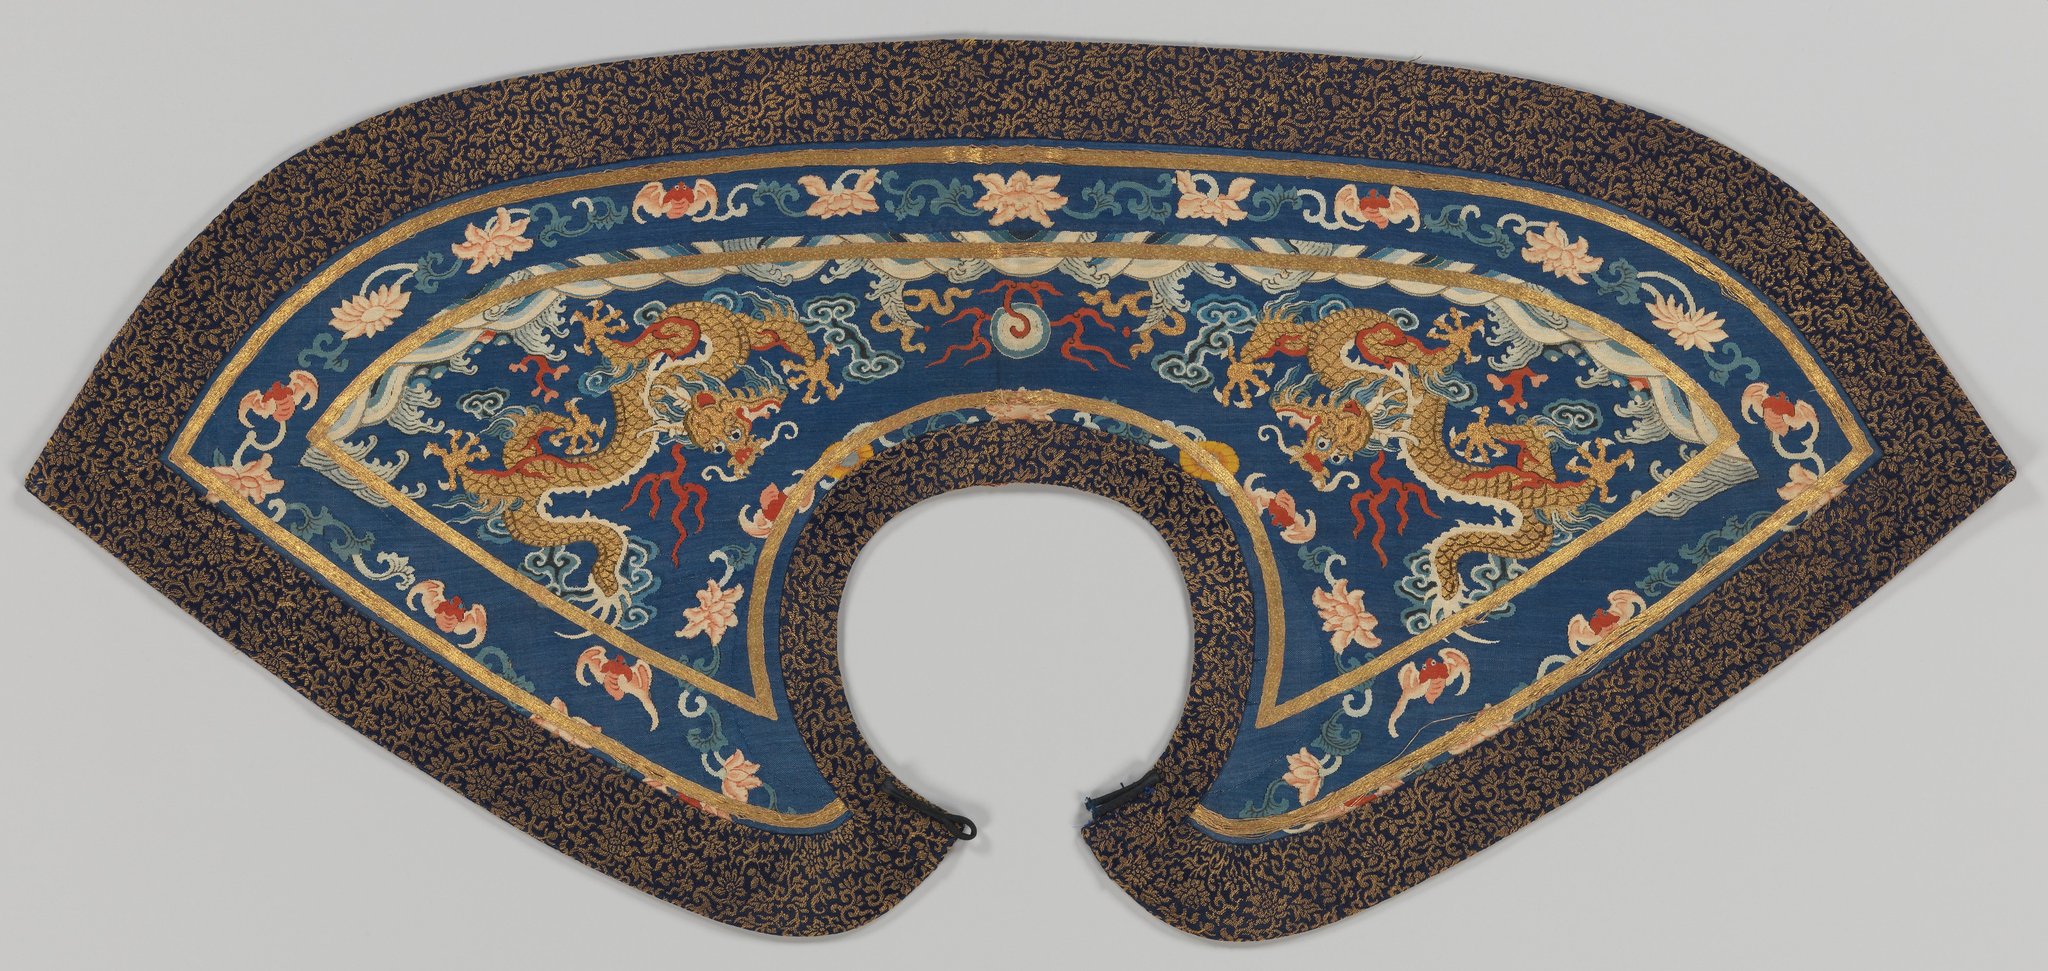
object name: collar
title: Formal Collar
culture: chinese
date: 1701-1800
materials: metal thread, silk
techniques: embroidery, painting, tapestry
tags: dragons,flowers